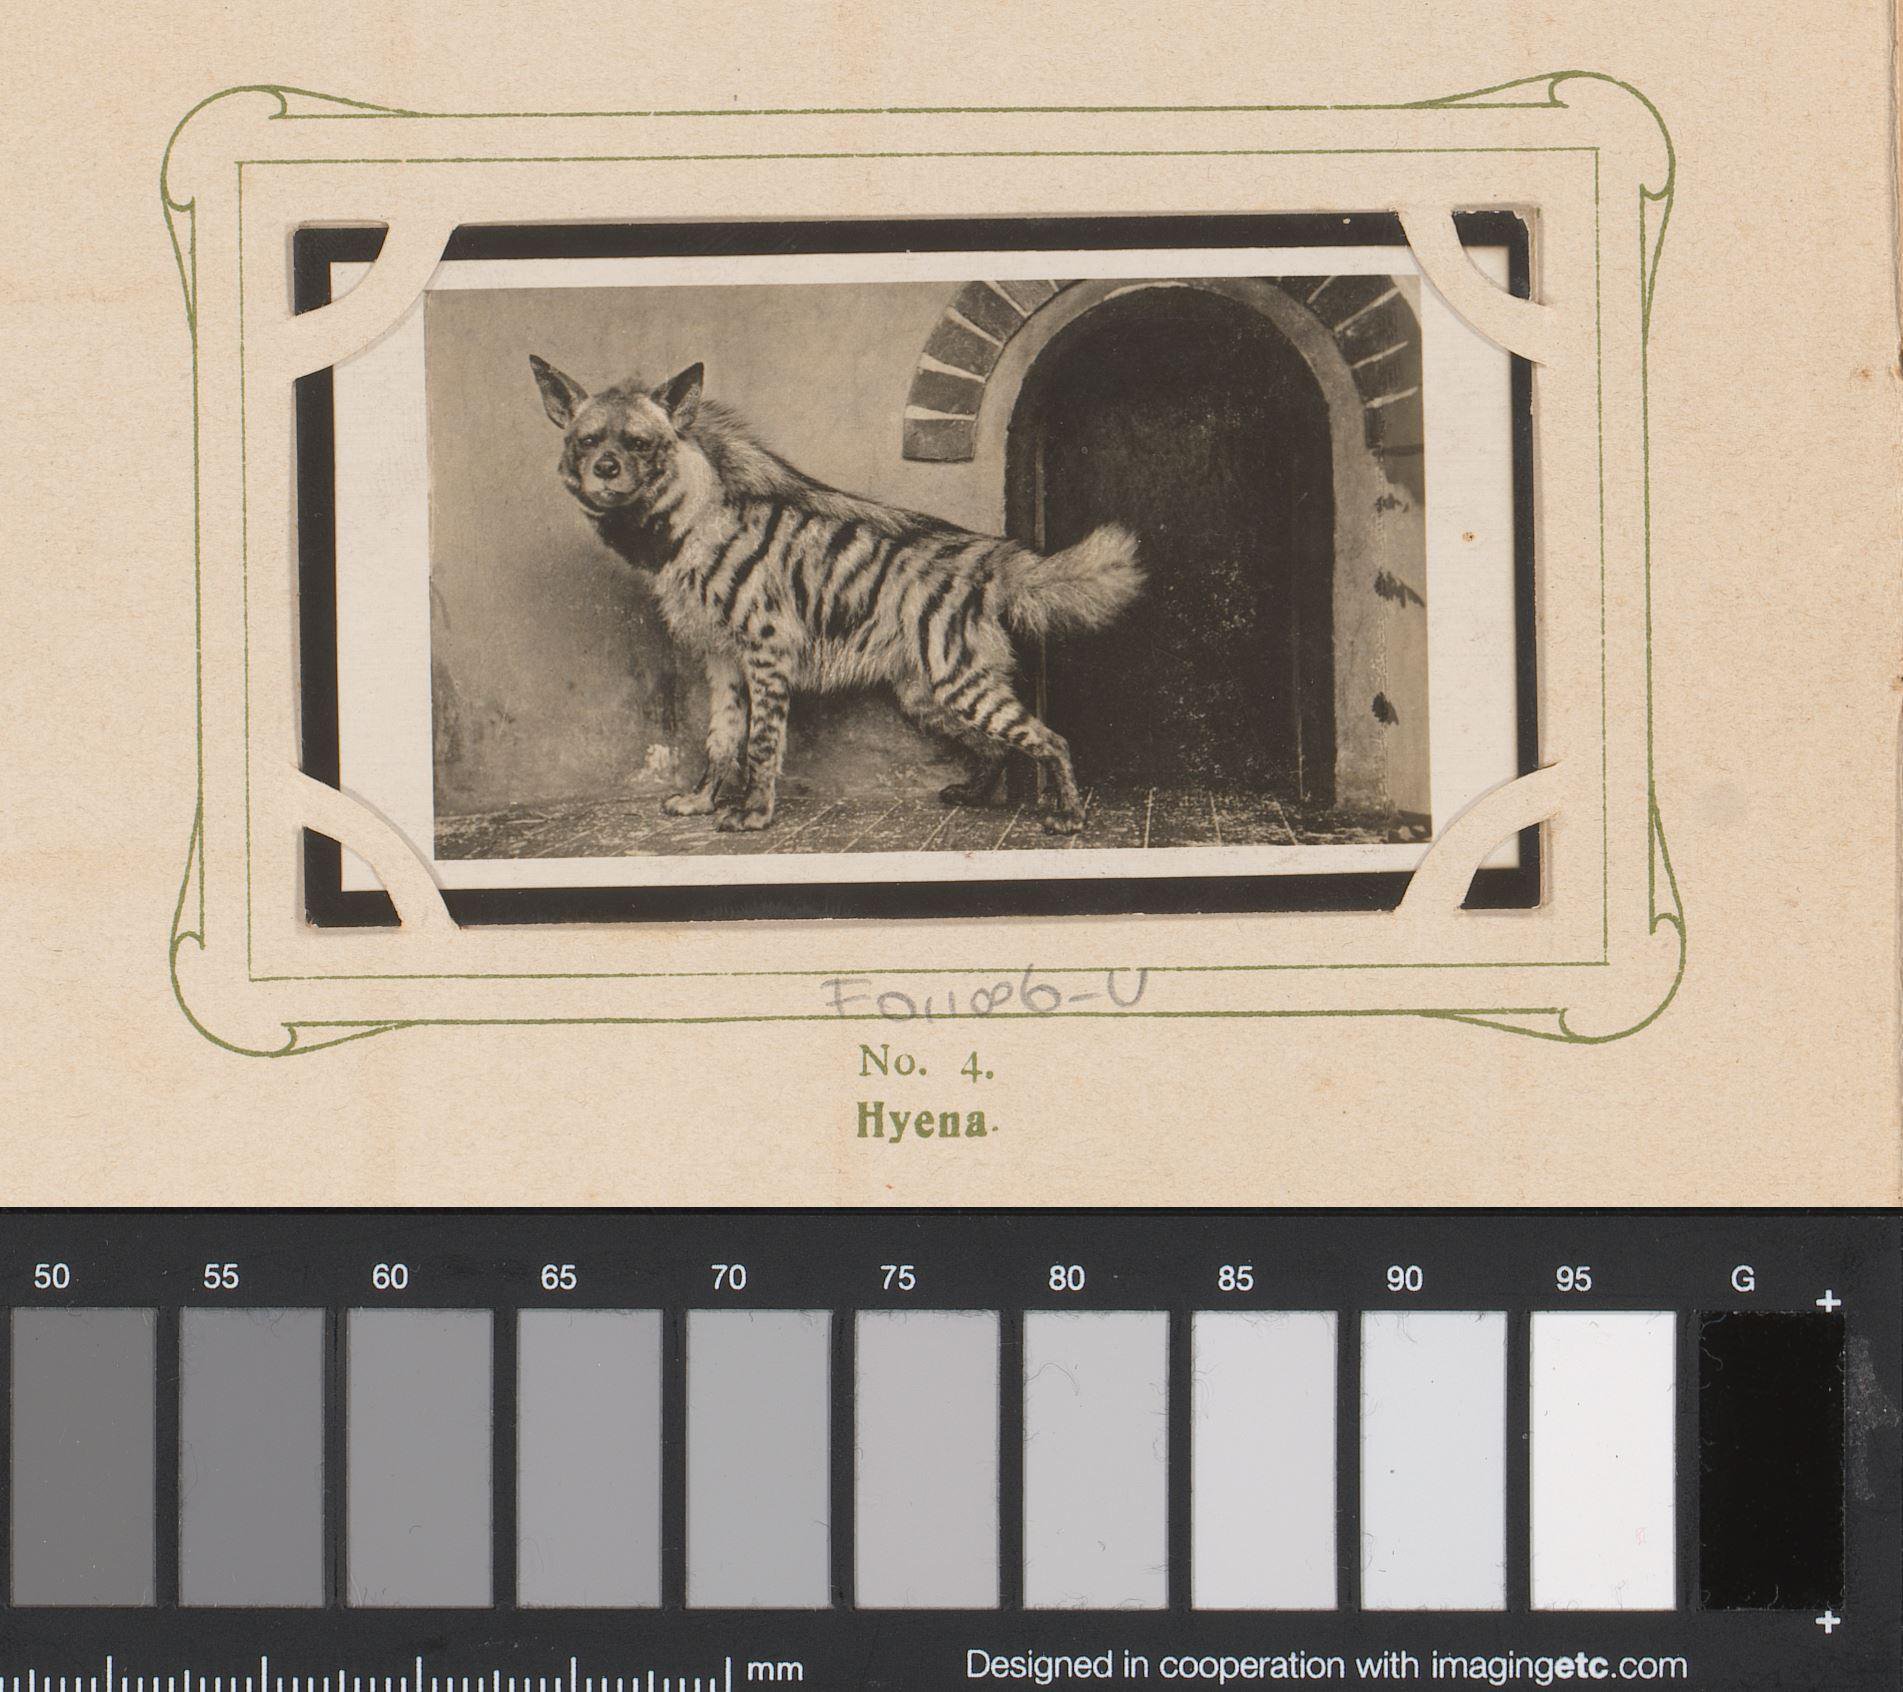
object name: album leaf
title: Staande Hyena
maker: Anonymous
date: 1904-1905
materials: photographic support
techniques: gelatin silver print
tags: beasts of prey, predatory animals: hyena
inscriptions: inscription: ‘No. 4./ Hyena.’